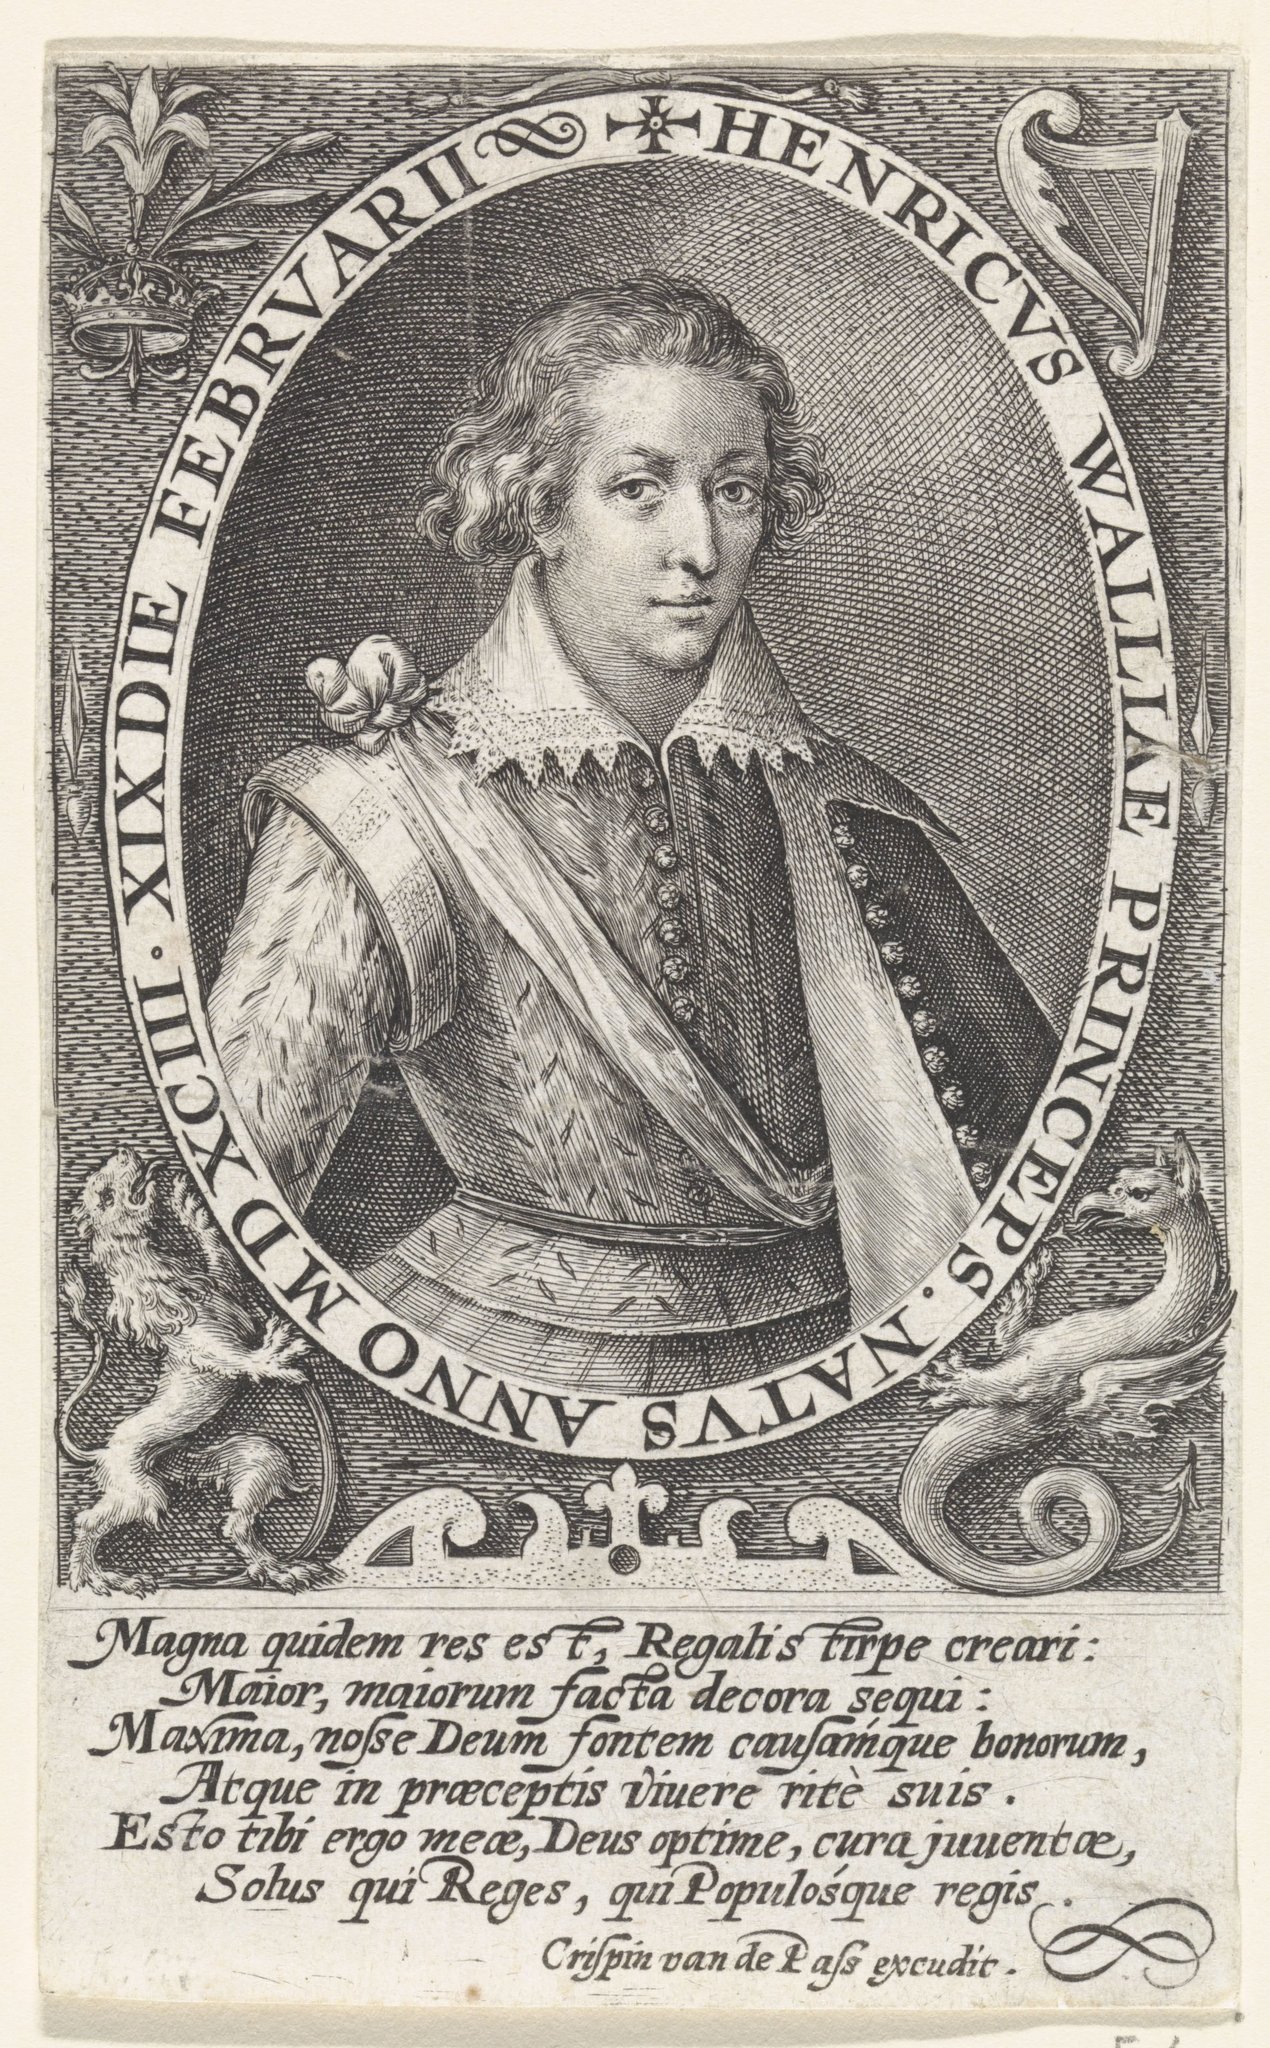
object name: print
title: Portret van Henry Frederick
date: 1574-1637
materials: paper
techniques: engraving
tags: fabulous animals (sometimes wrongly called 'grotesques'); 'mostri' (ripa), harp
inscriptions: collector's mark: Lugt 2760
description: Portret van Henry Frederick, prins van Wales. In de hoeken twee fabeldieren, een kroon met lelie en een harp. In het randschrift van de omlijsting de naam, functie en geboortedatum van de geportretteerde in het Latijn. In de marge een zesregelig lofdicht in het Latijn.